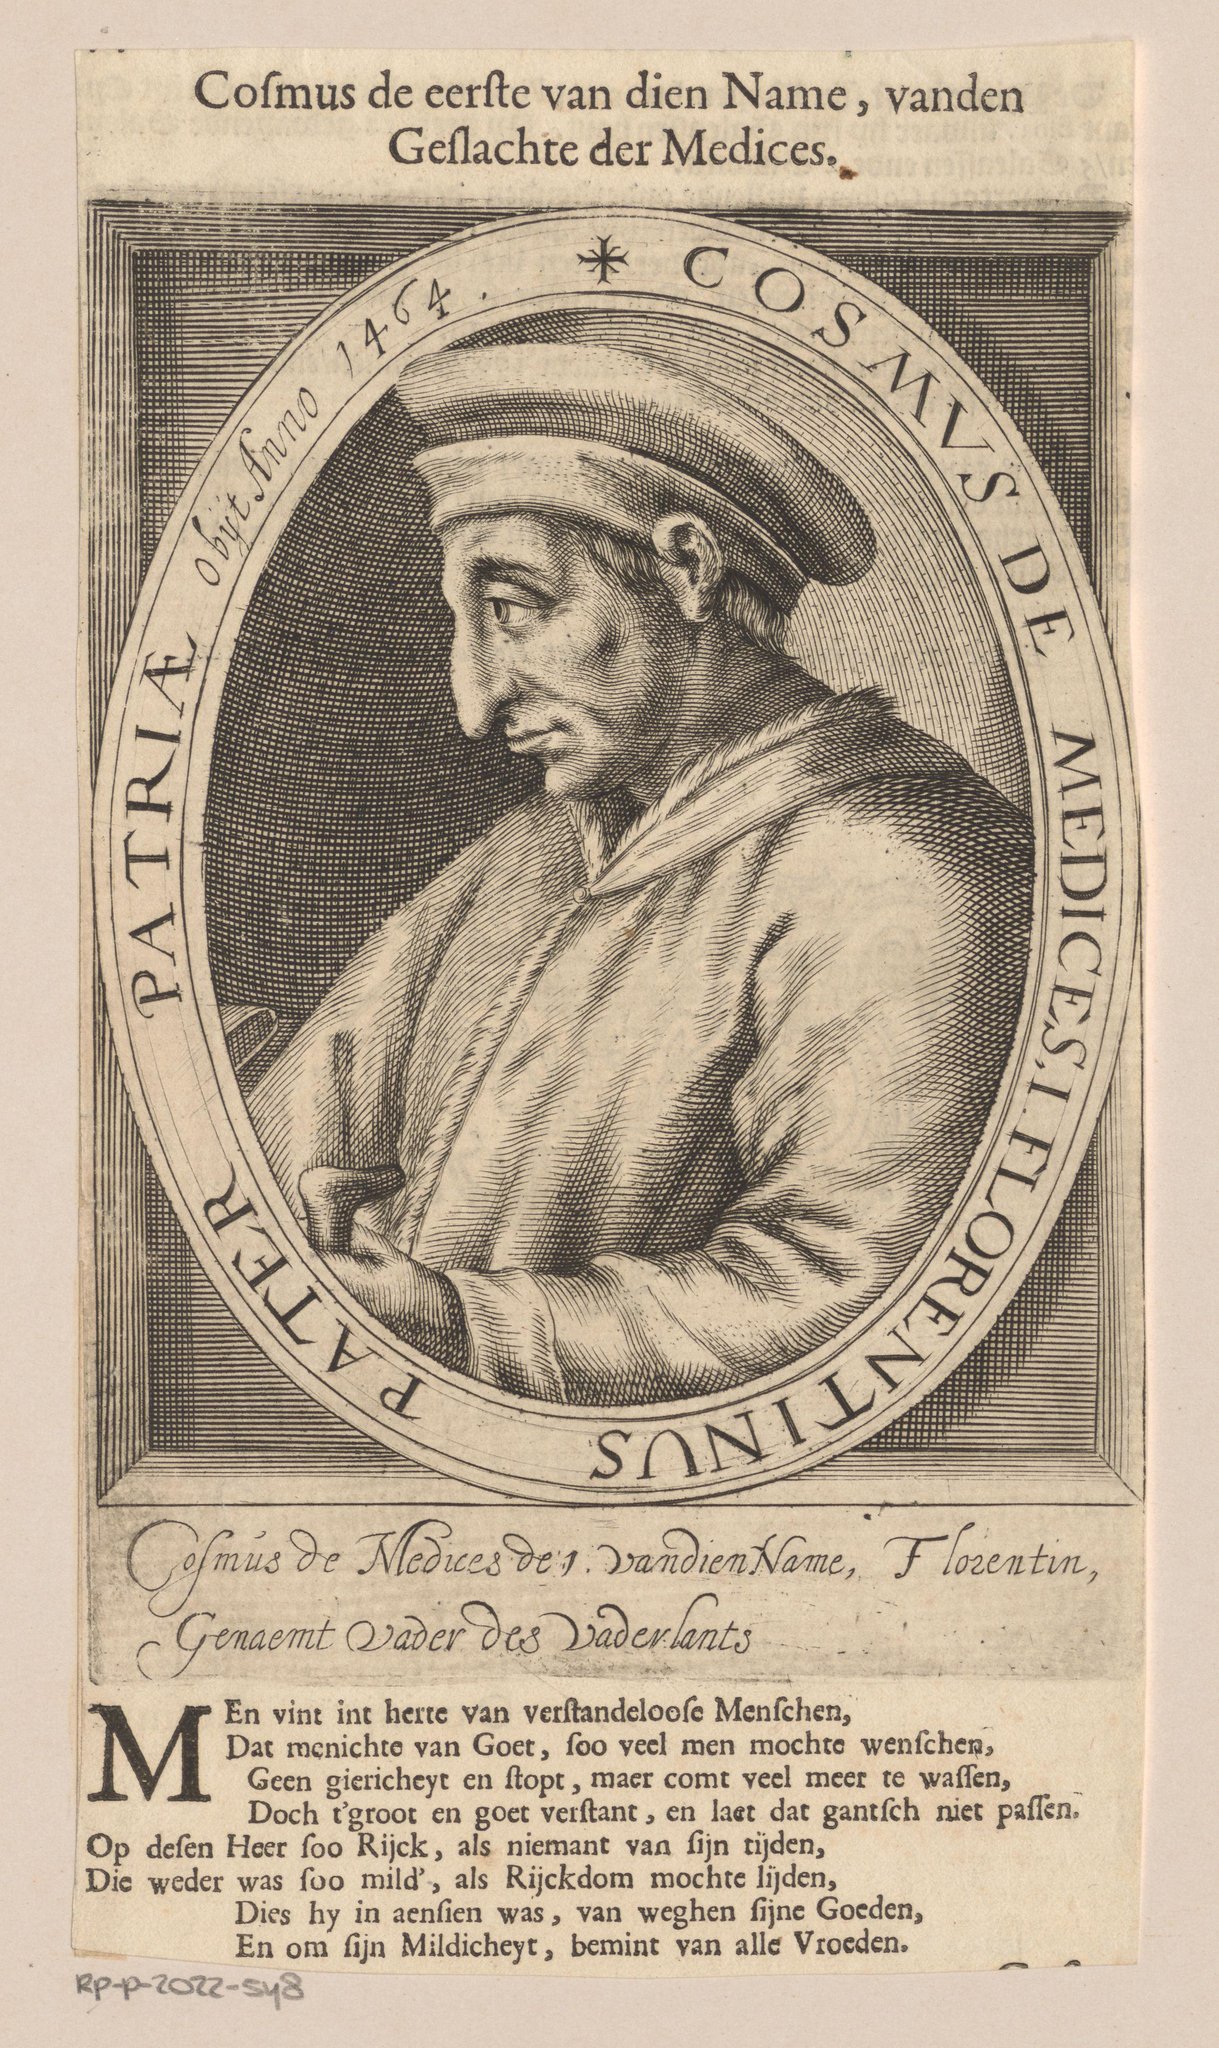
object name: book illustration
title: Cosmus de Medices, I. Florentinus Pater Patrae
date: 1617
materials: paper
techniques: engraving, letterpress printing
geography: delft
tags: cosimo i de' medici, historical persons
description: Prent uit: Clerck, Nicolaes de. Tooneel der beroemder hertogen princen graven ende krygs-helden van christenrijck. Delft: Nicolaes de Clerck, 1617, p. 440.